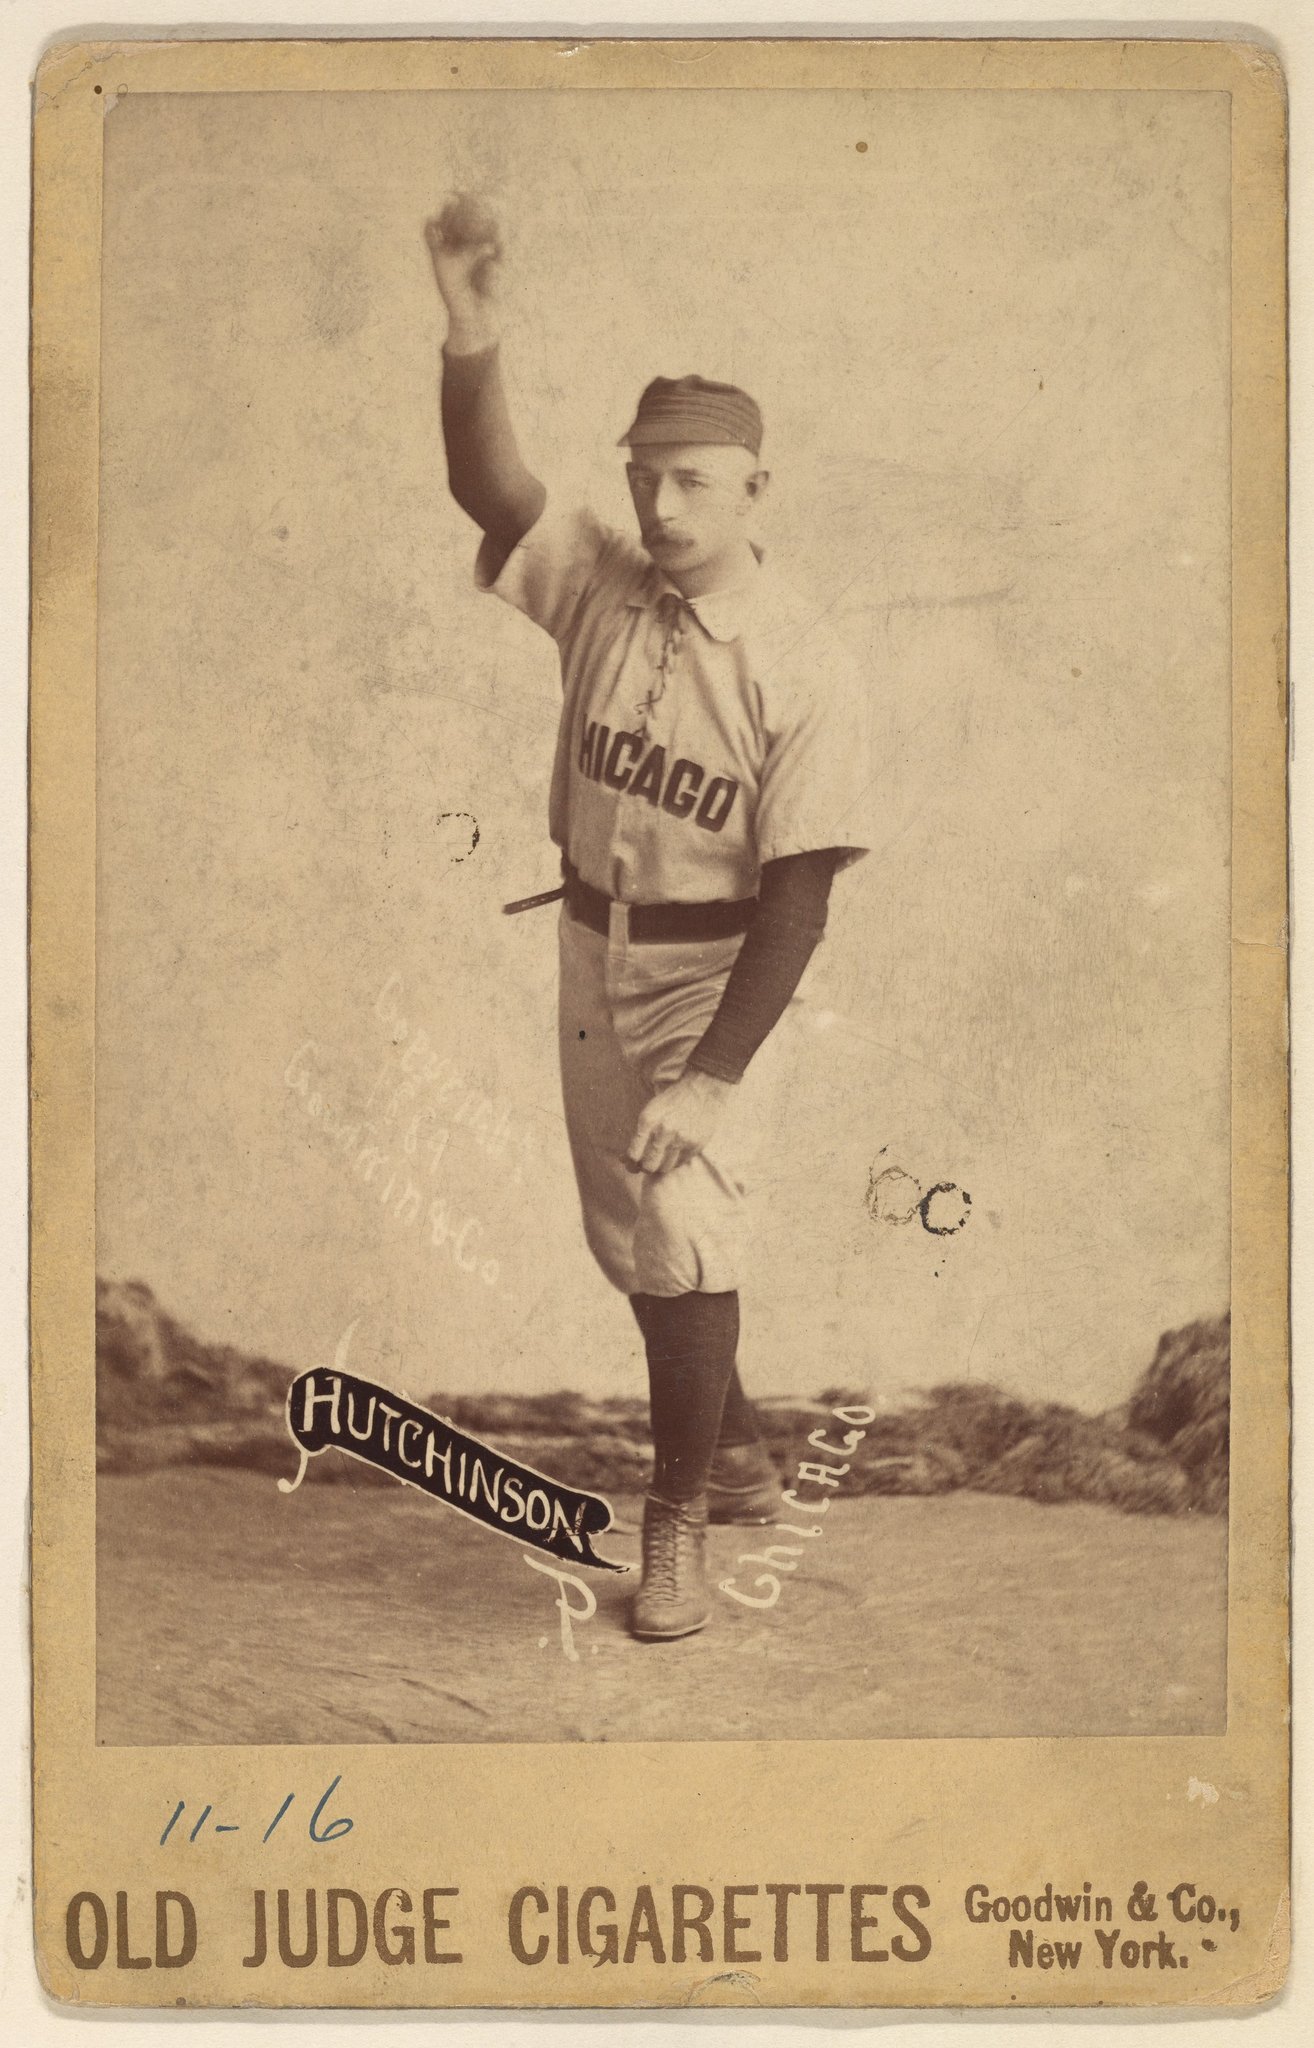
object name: baseball card, photograph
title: William Forest "Wild Bill" Hutchinson, Pitcher, Chicago, from the series Old Judge Cigarettes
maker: goodwin & company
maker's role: publisher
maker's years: 1850-1950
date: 1889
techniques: albumen silver print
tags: men,portraits,baseball,athletes